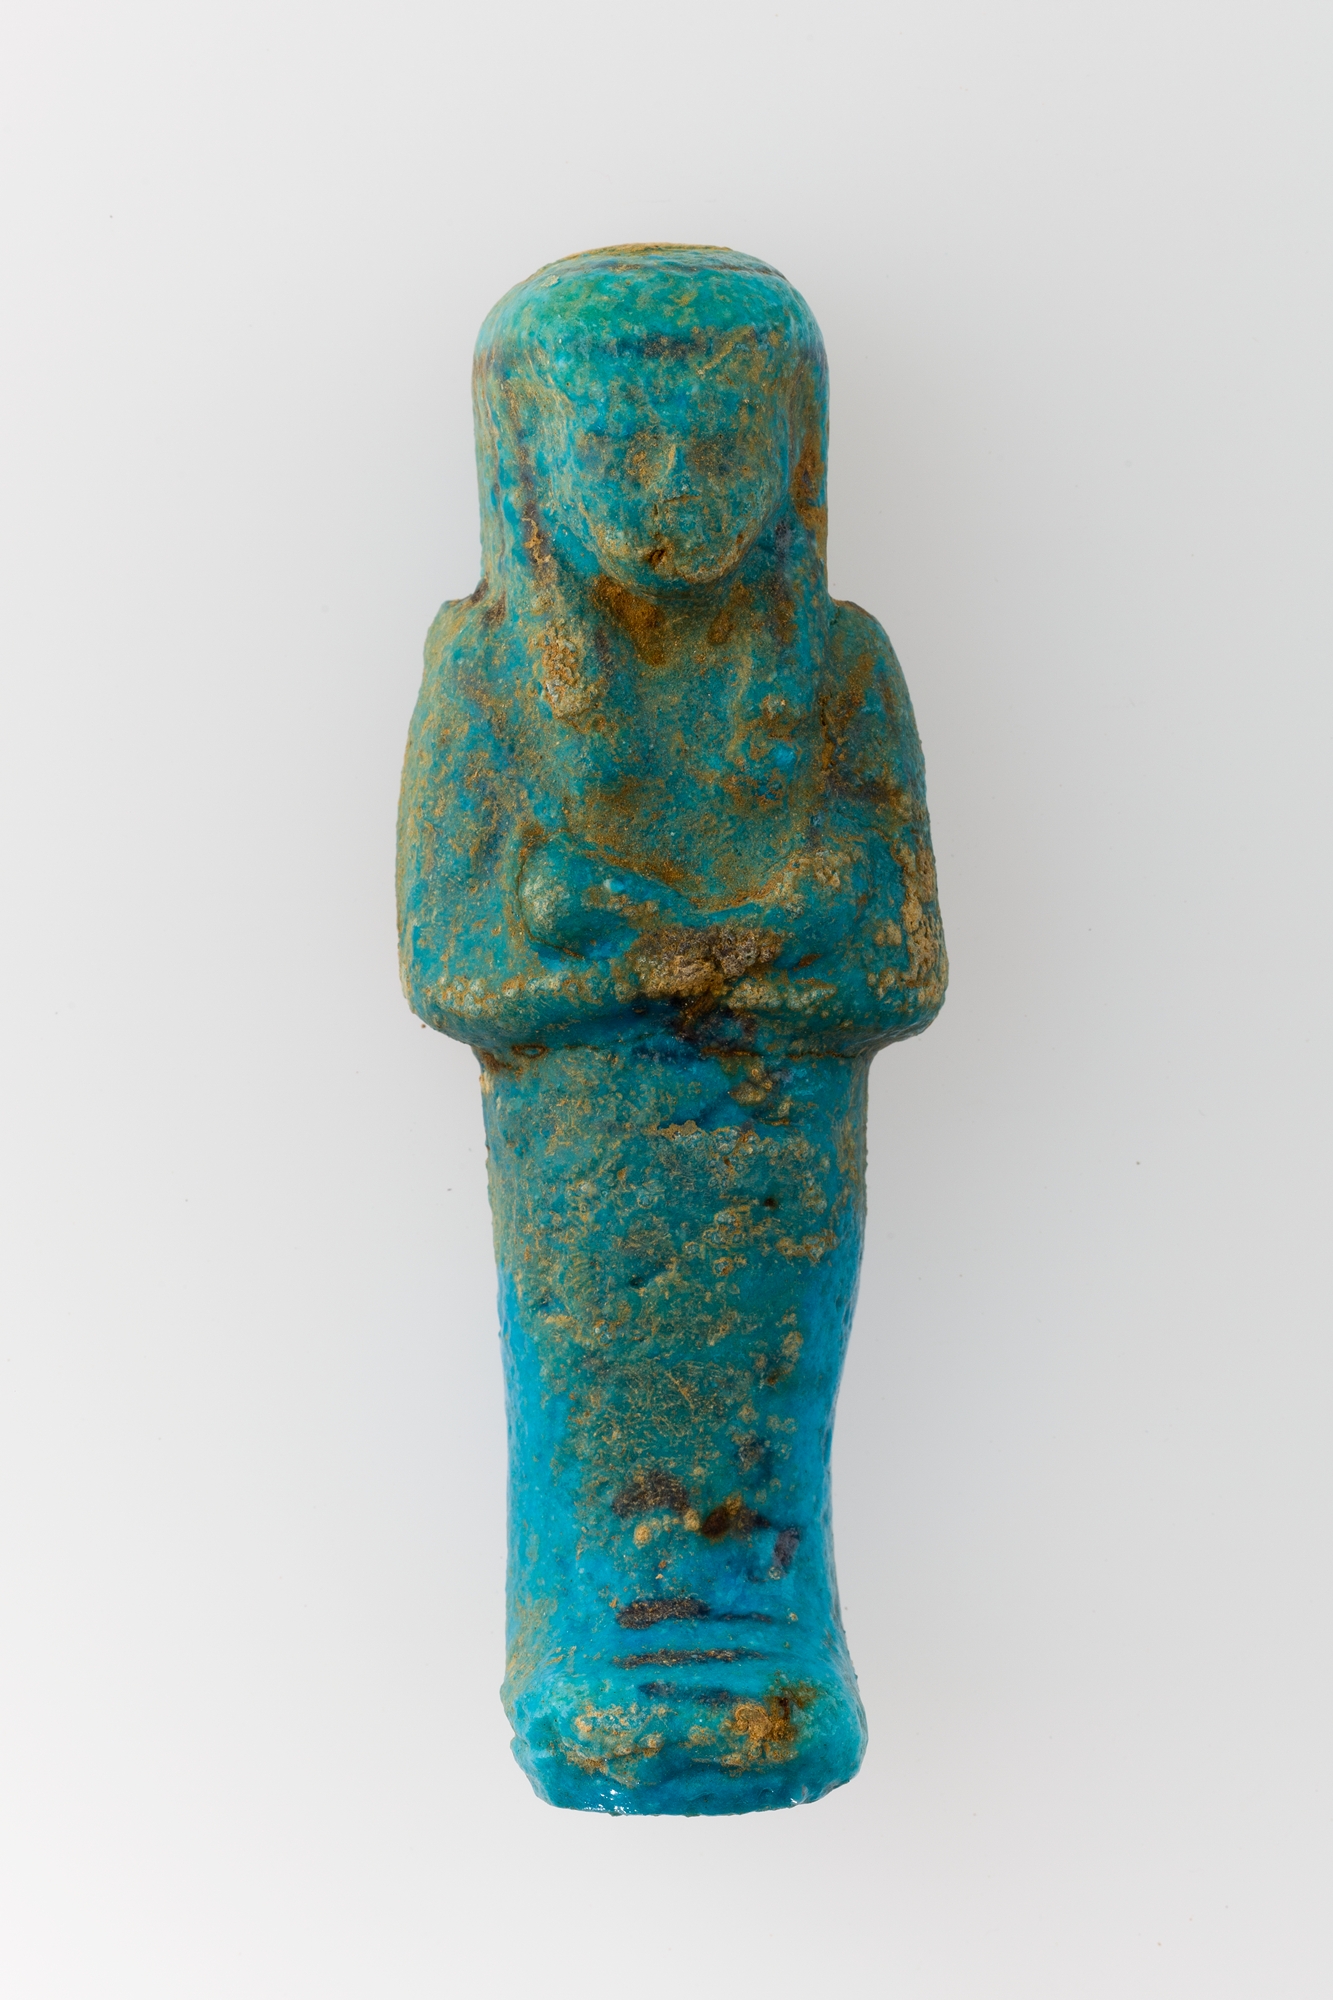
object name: shabti, henettawy c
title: Worker Shabti of Henettawy (C), Daughter of Isetemkheb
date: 990-970 BCE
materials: faience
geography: egypt